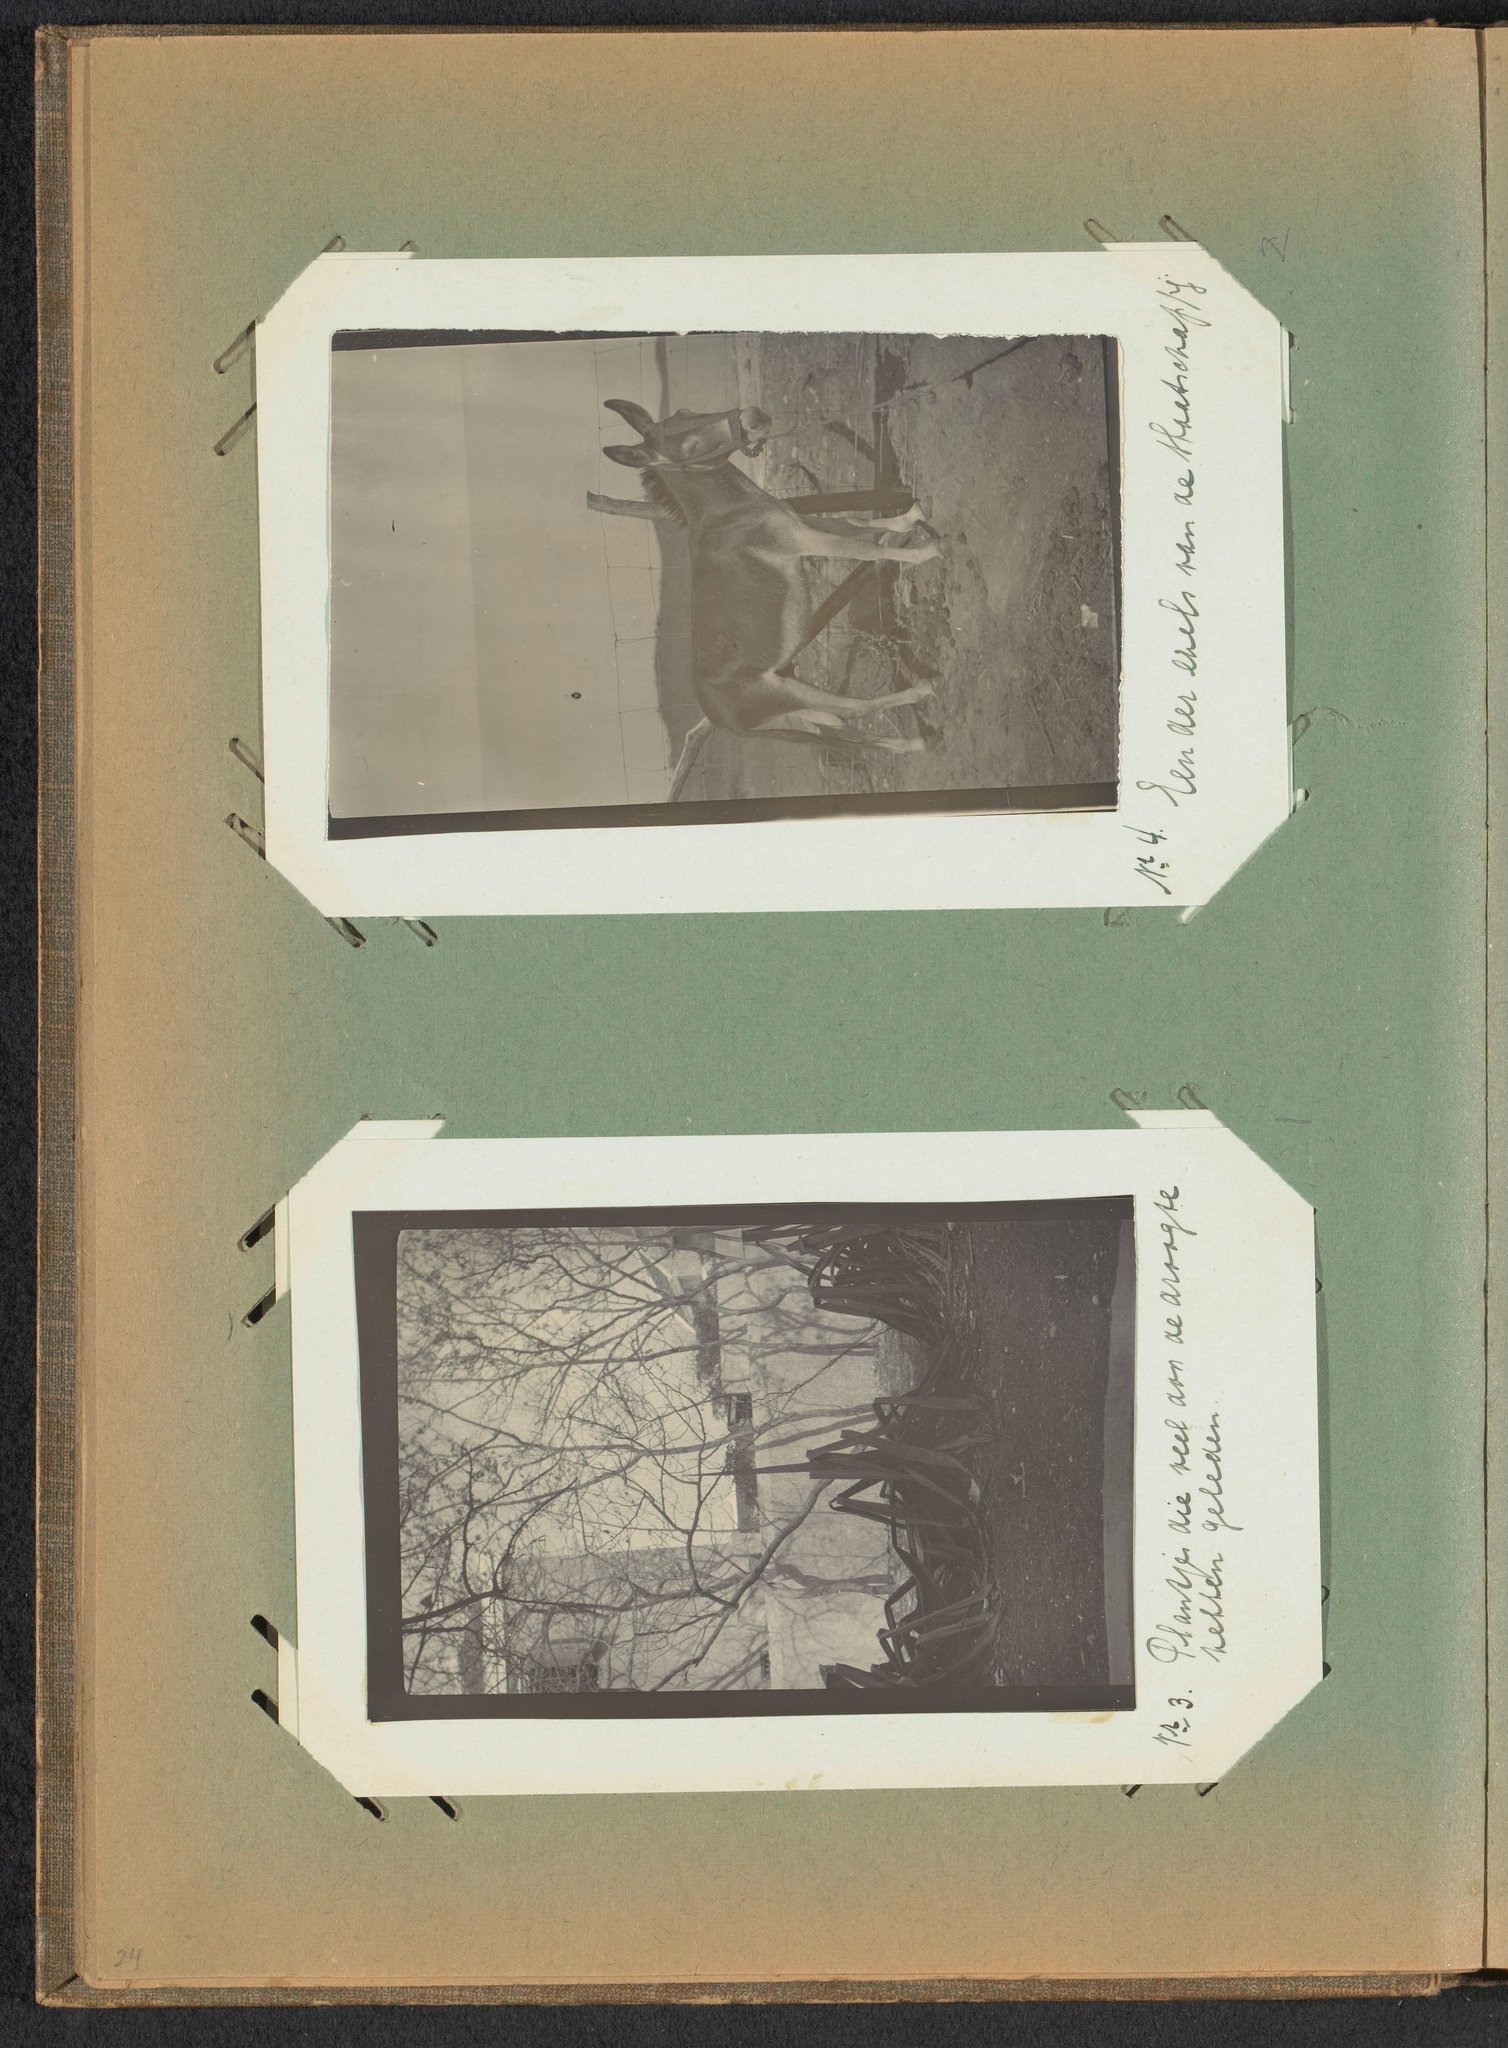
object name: photograph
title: Nr. 4 Een der ezels van de Maatschappij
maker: Anonymous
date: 1912-1913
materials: paper, photographic support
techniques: gelatin silver print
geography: curacao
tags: plantation, ass, donkey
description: Ezel behorend bij plantage Mount Pleasant op Curaçao. Onderdeel van het fotoalbum uit ca. 1912-1913 met 92 foto's van de plantages Peperpot en Dordrecht in Suriname en Mount Pleasant op Curaçao.